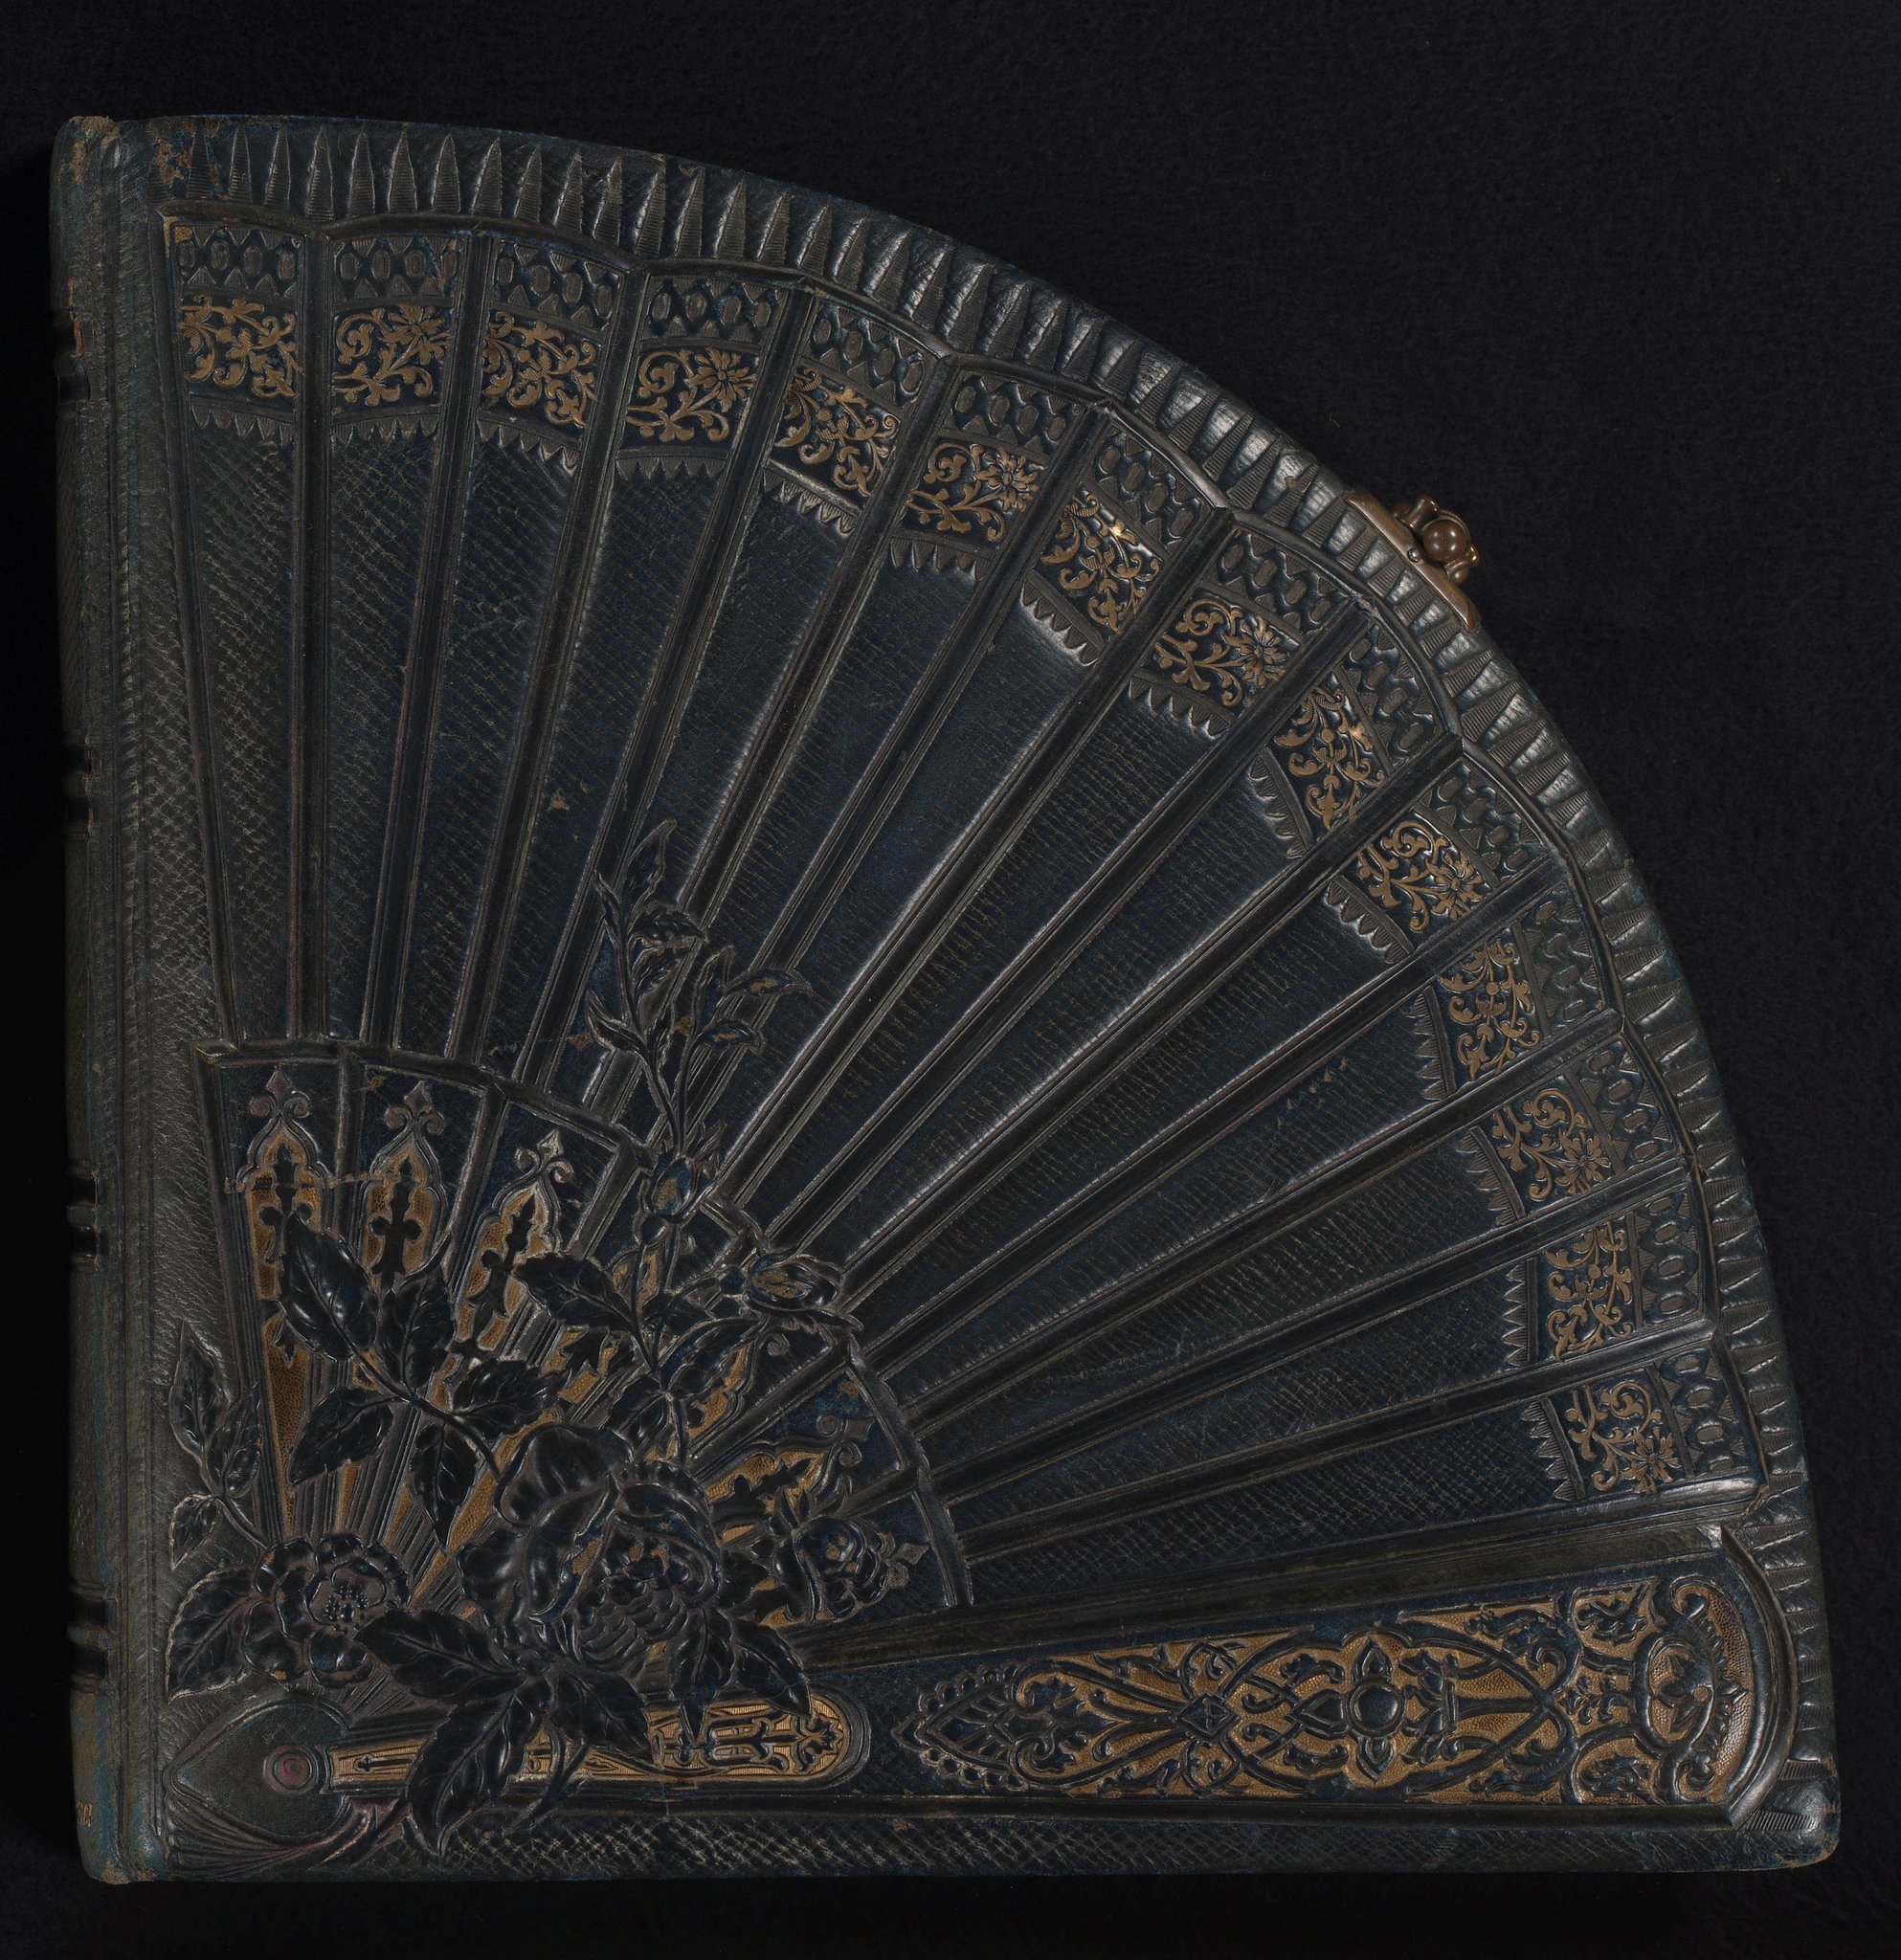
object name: slip in album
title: Familiealbum van John en Annie Boer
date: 1899-1940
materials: cardboard, hair, leather, metal, paper, photographic support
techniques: decorated paper, gelatin silver print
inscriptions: annotation: ‘To Annie Boer as a Birthday Present from her loving husband John/ January 21st 1899’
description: Familiealbum, vermoedelijk van de familie Boer, met 26 pagina's met in totaal 27 foto's. Op het eerste schutblad staat een boodschap van John Boer aan zijn vrouw Annie Boer en op het tweede schutblad zijn verschillende krantenknipsels geplakt waarin Annie en John Boer genoemd worden als leden van de Turret Green Christian Endeavour Society. Op het laatste schutblad is een portret geplakt. Het album bevat voornamelijk portretten, waarvan enkele kabinetfoto's en cartes-de-visite, van mannen, vrouwen en honden.